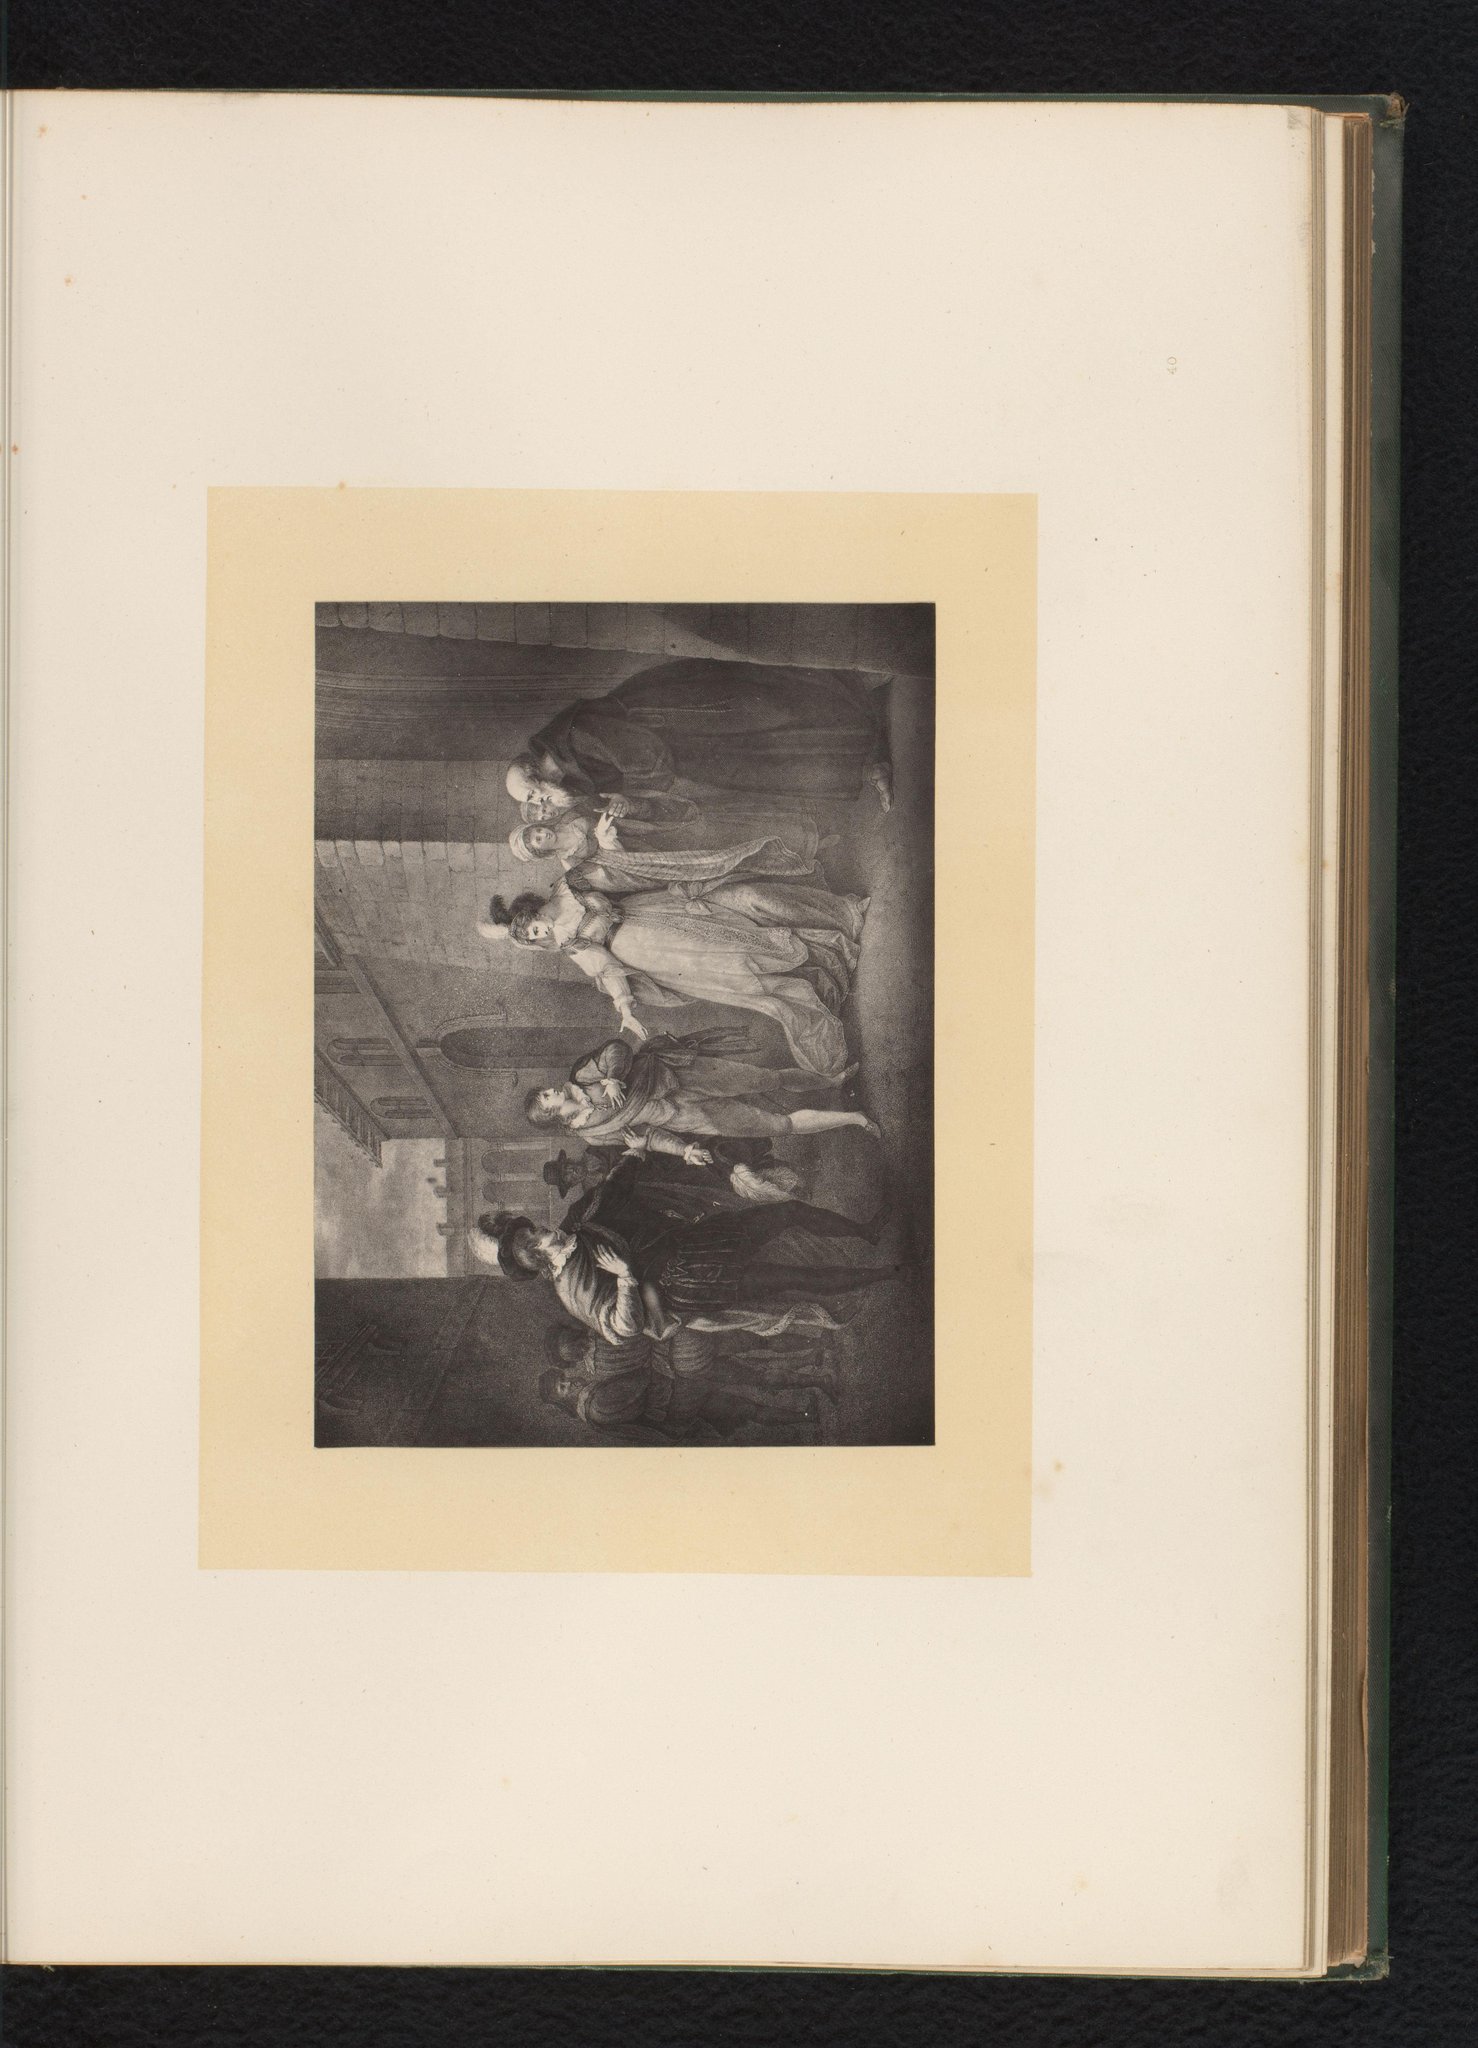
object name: reproduction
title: Reproductie van een gravure naar een schilderij van een scène uit Twelfth Night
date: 1874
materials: paper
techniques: woodburytype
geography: london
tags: comedy